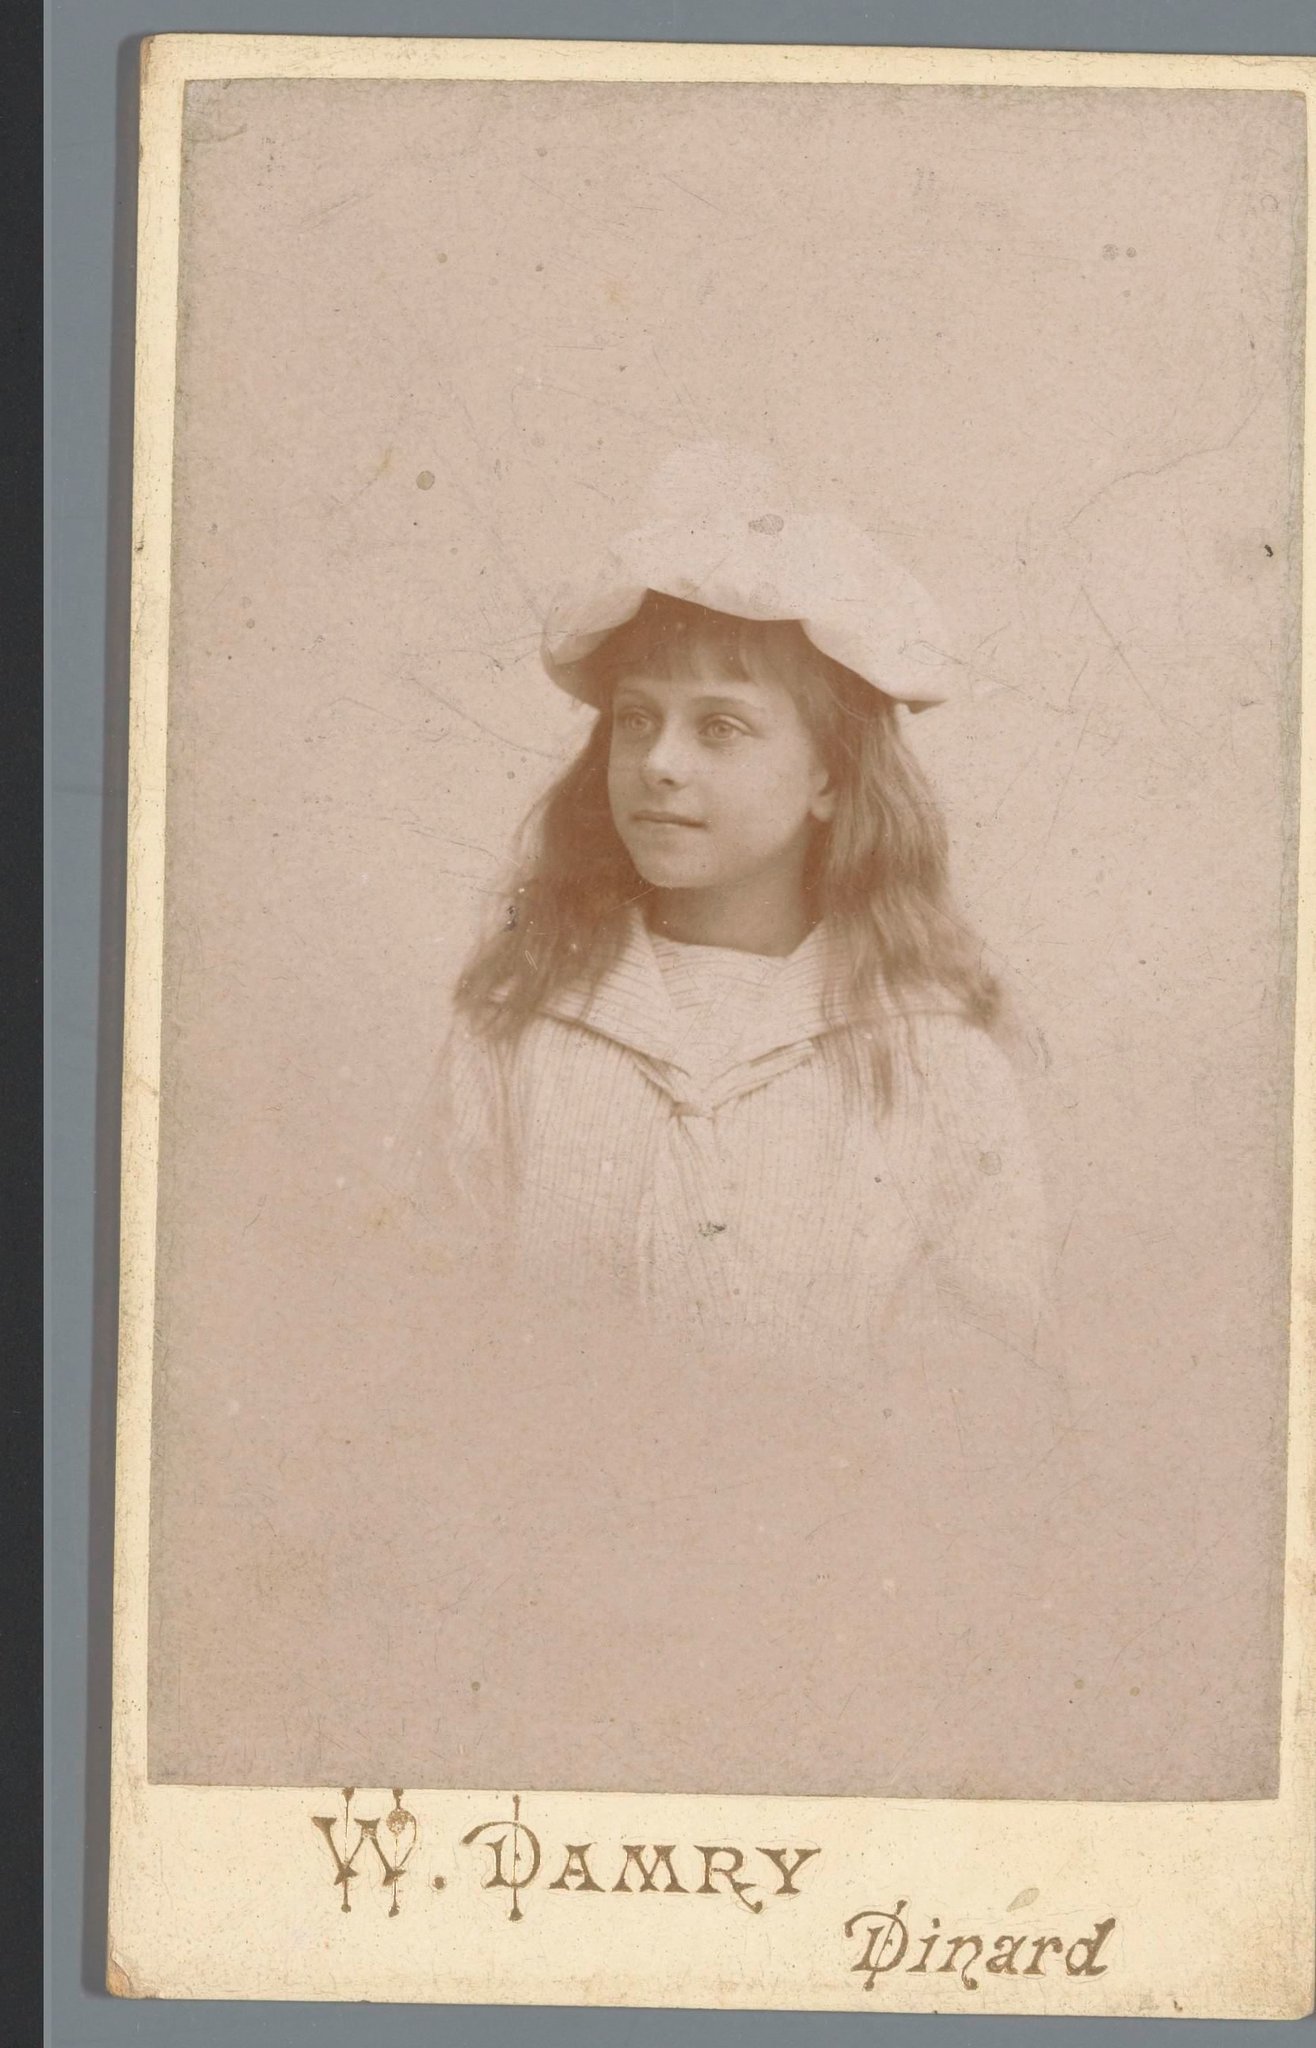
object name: carte de visite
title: Portret van een onbekend meisje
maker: walter damry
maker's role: fotograaf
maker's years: 1833-1890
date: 1892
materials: paper, cardboard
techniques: gelatin silver print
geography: dinard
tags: girl (child between toddler and youth), anonymous historical person portrayed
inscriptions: inscription: ‘W. Damry/ Dinard’, inscription: ‘W. Damry/ Villa Claudine/ Dinard/ Spécialité d'Agrandissements Inaltérables/ Tochon-Lepage - Paris’, date: ‘1892’